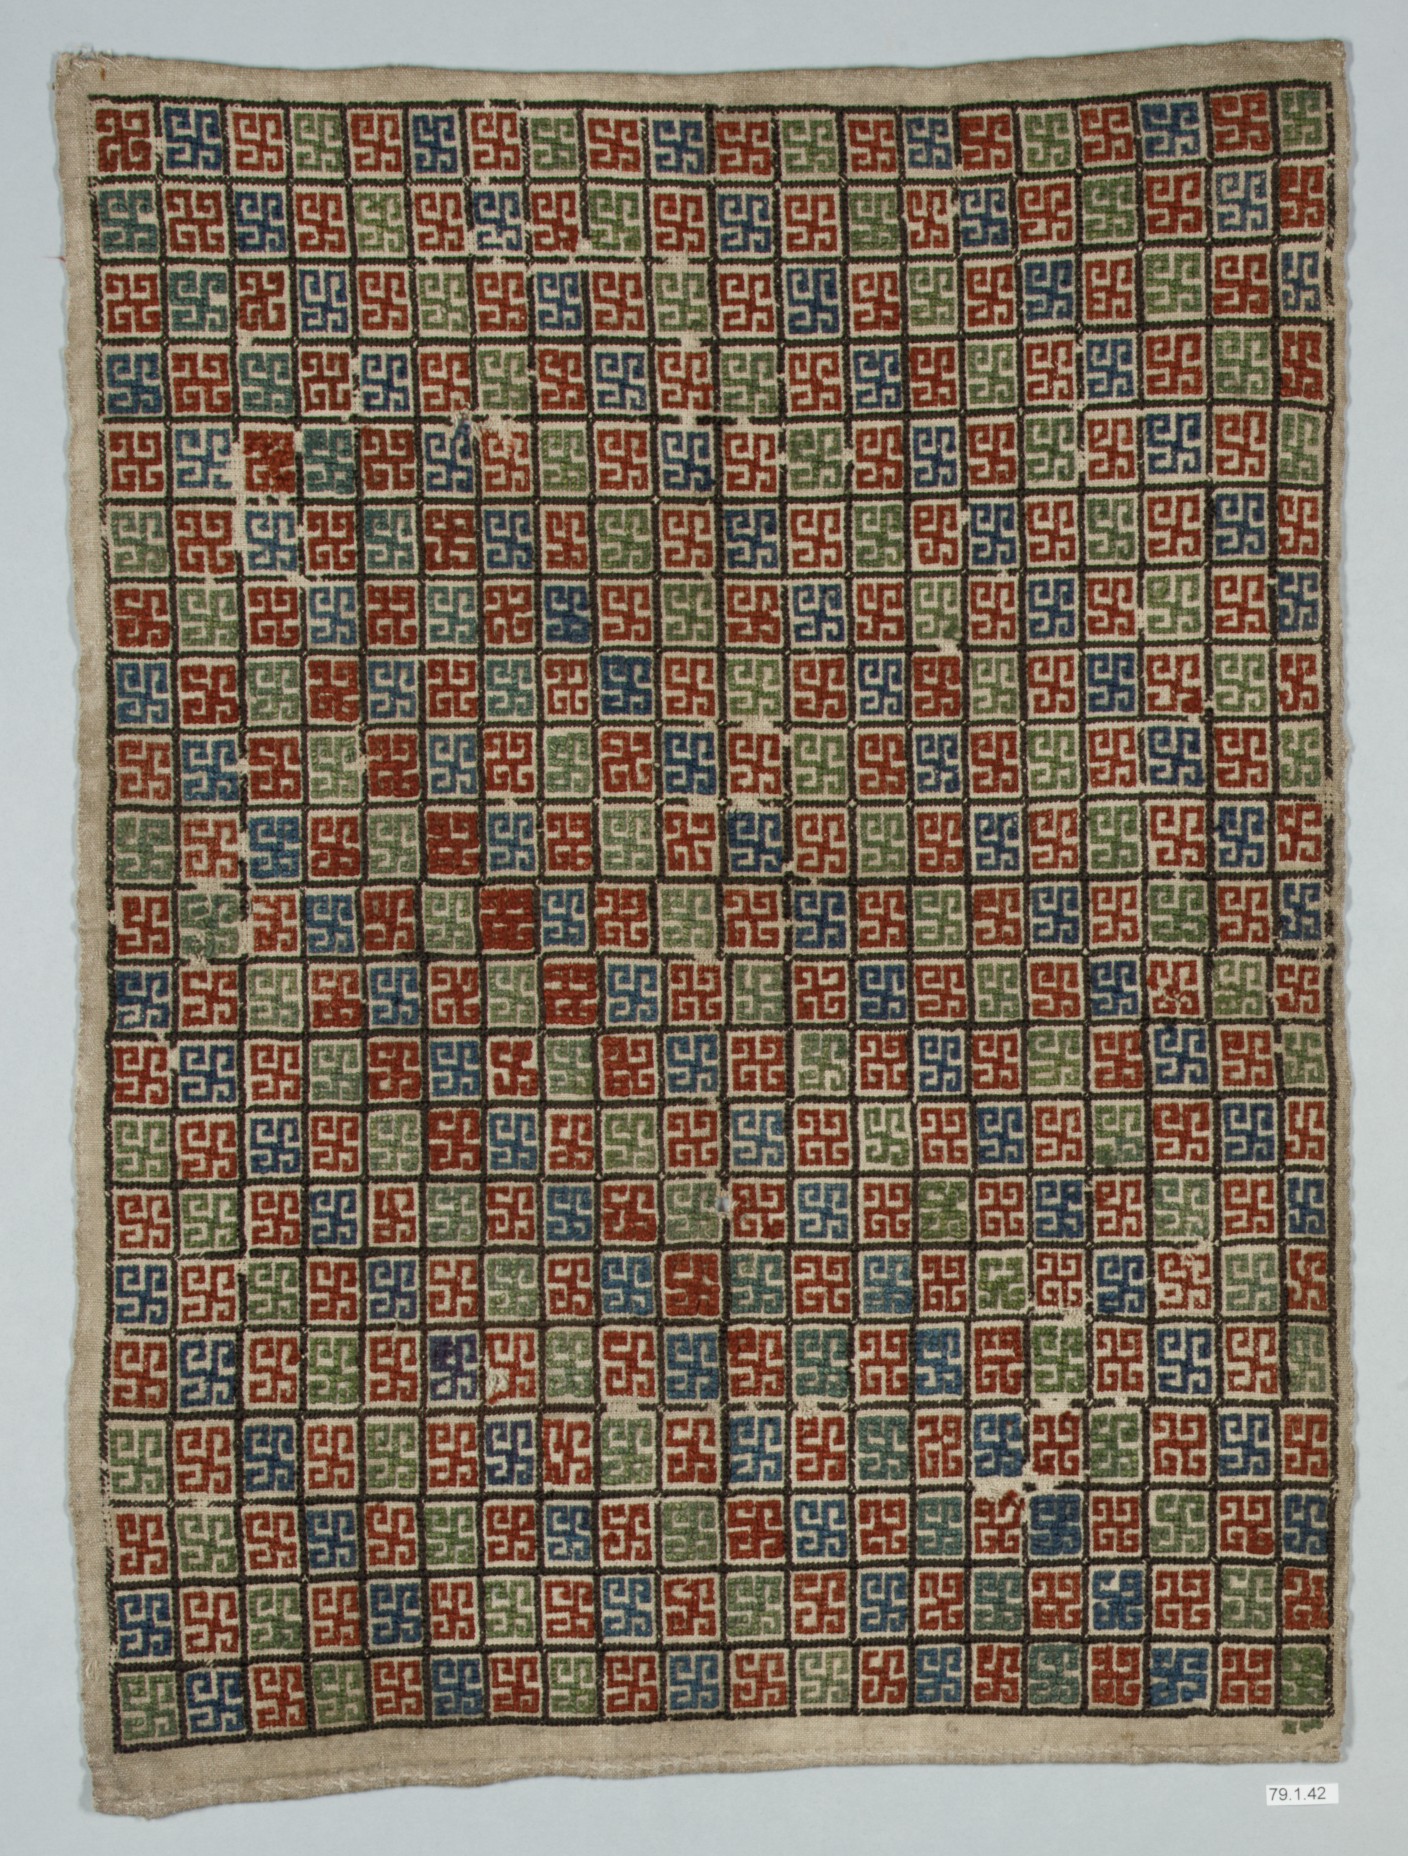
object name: cover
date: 1801-1833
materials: linen, silk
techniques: embroidery, weave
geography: greece